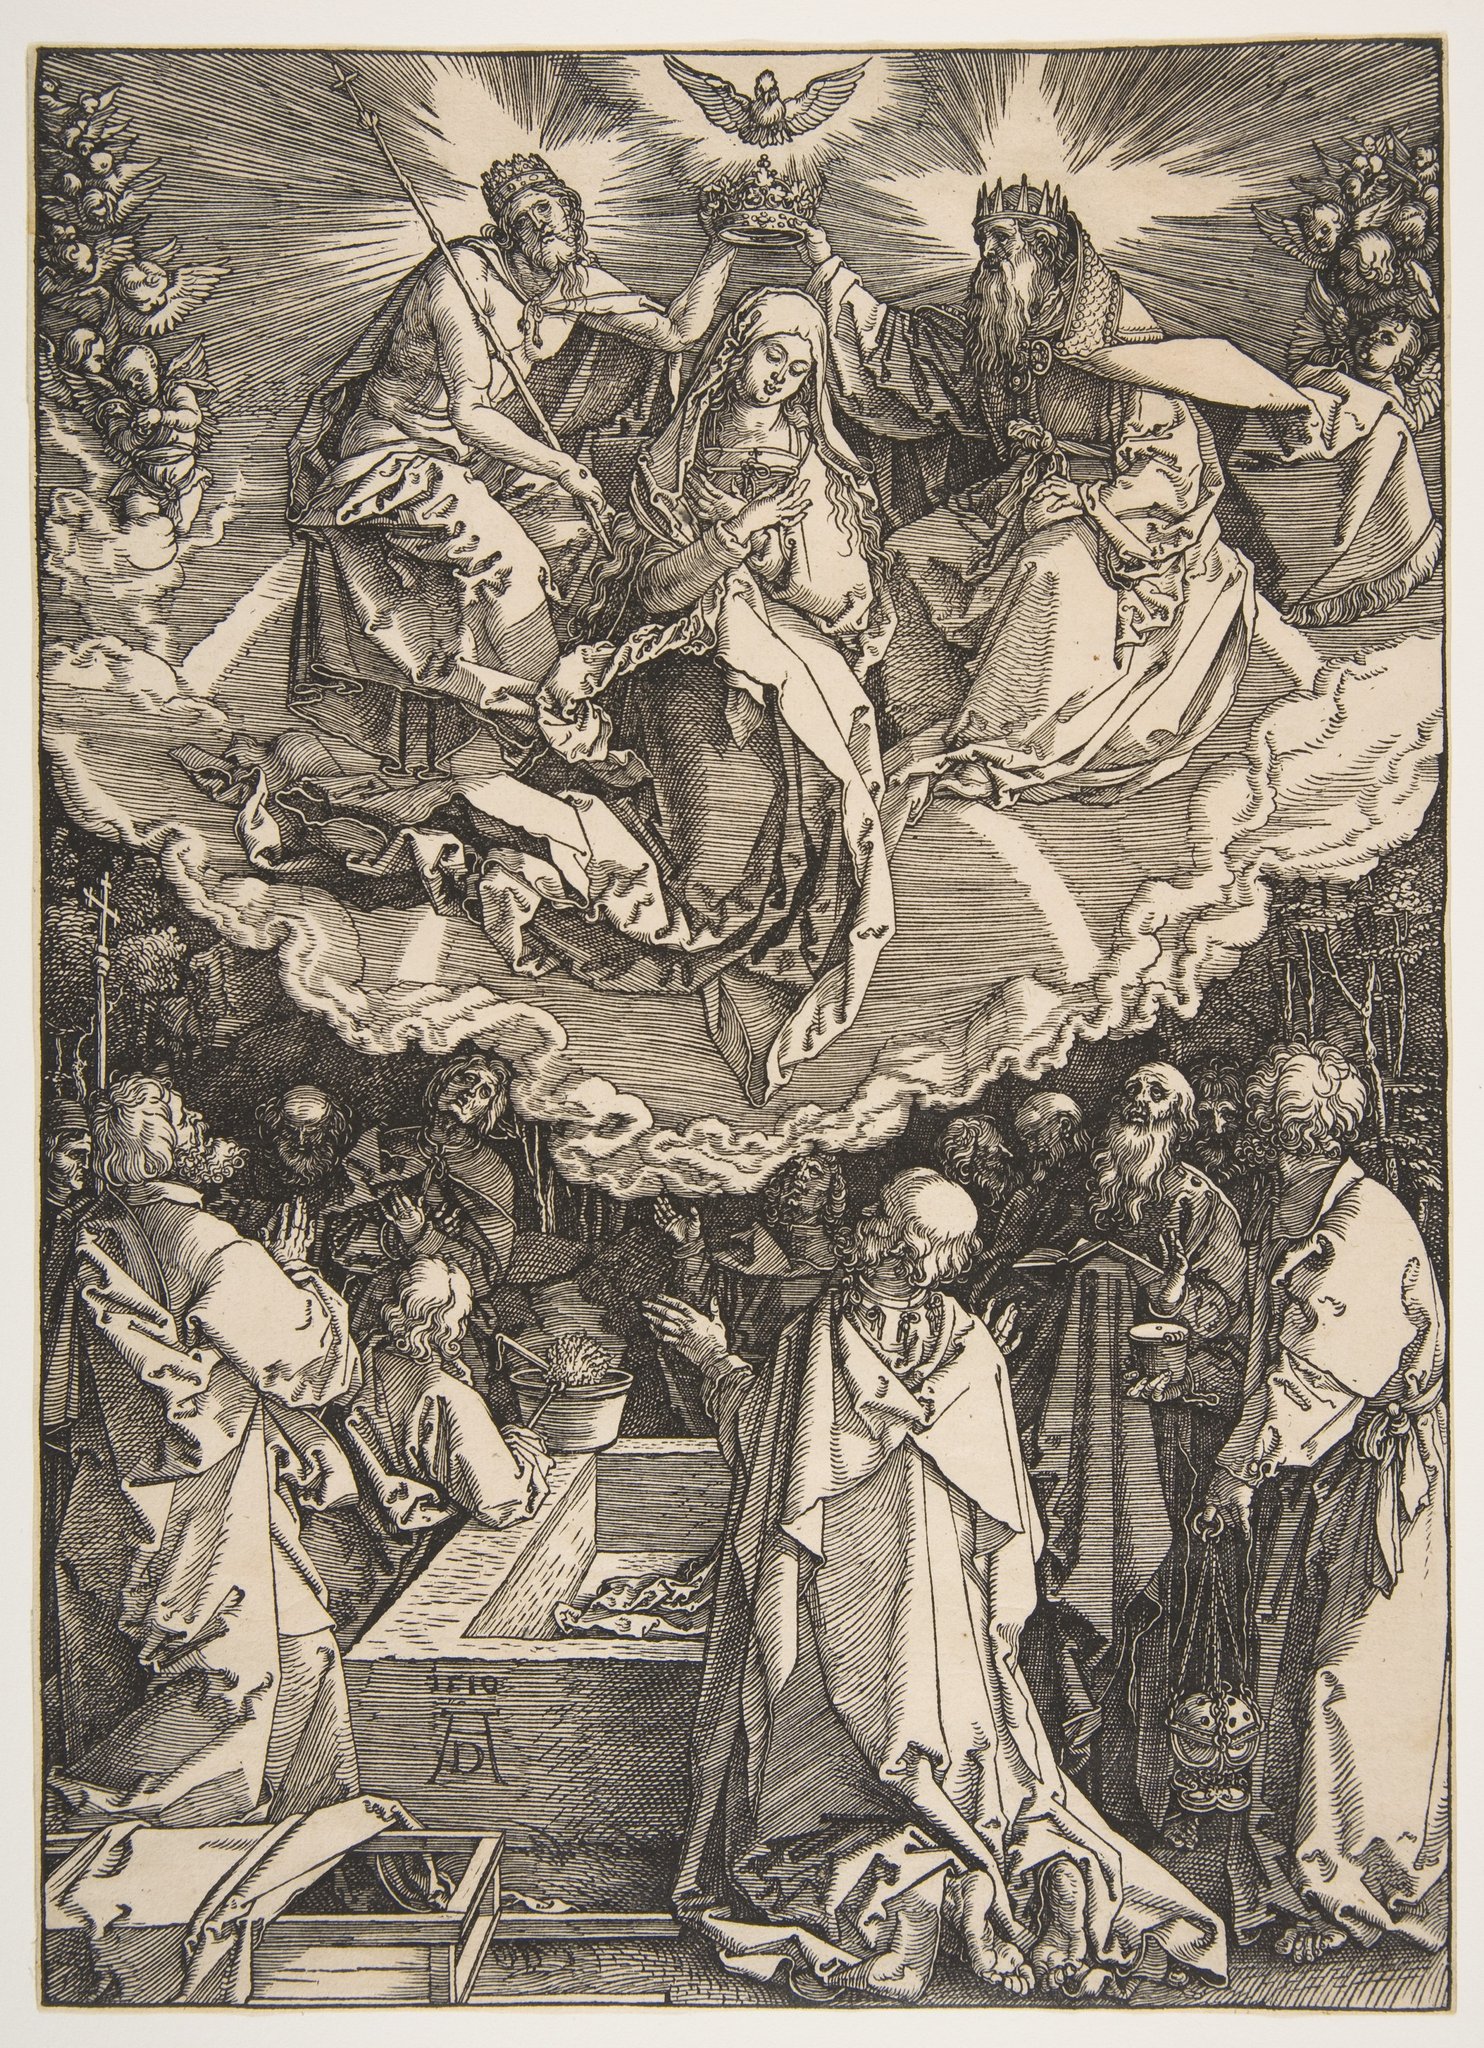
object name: print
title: The Assumption and Coronation of the Virgin, from The Life of the Virgin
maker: albrecht dürer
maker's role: artist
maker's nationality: german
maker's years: 1471-1528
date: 1510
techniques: woodcut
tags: men,angels,assumption of the virgin